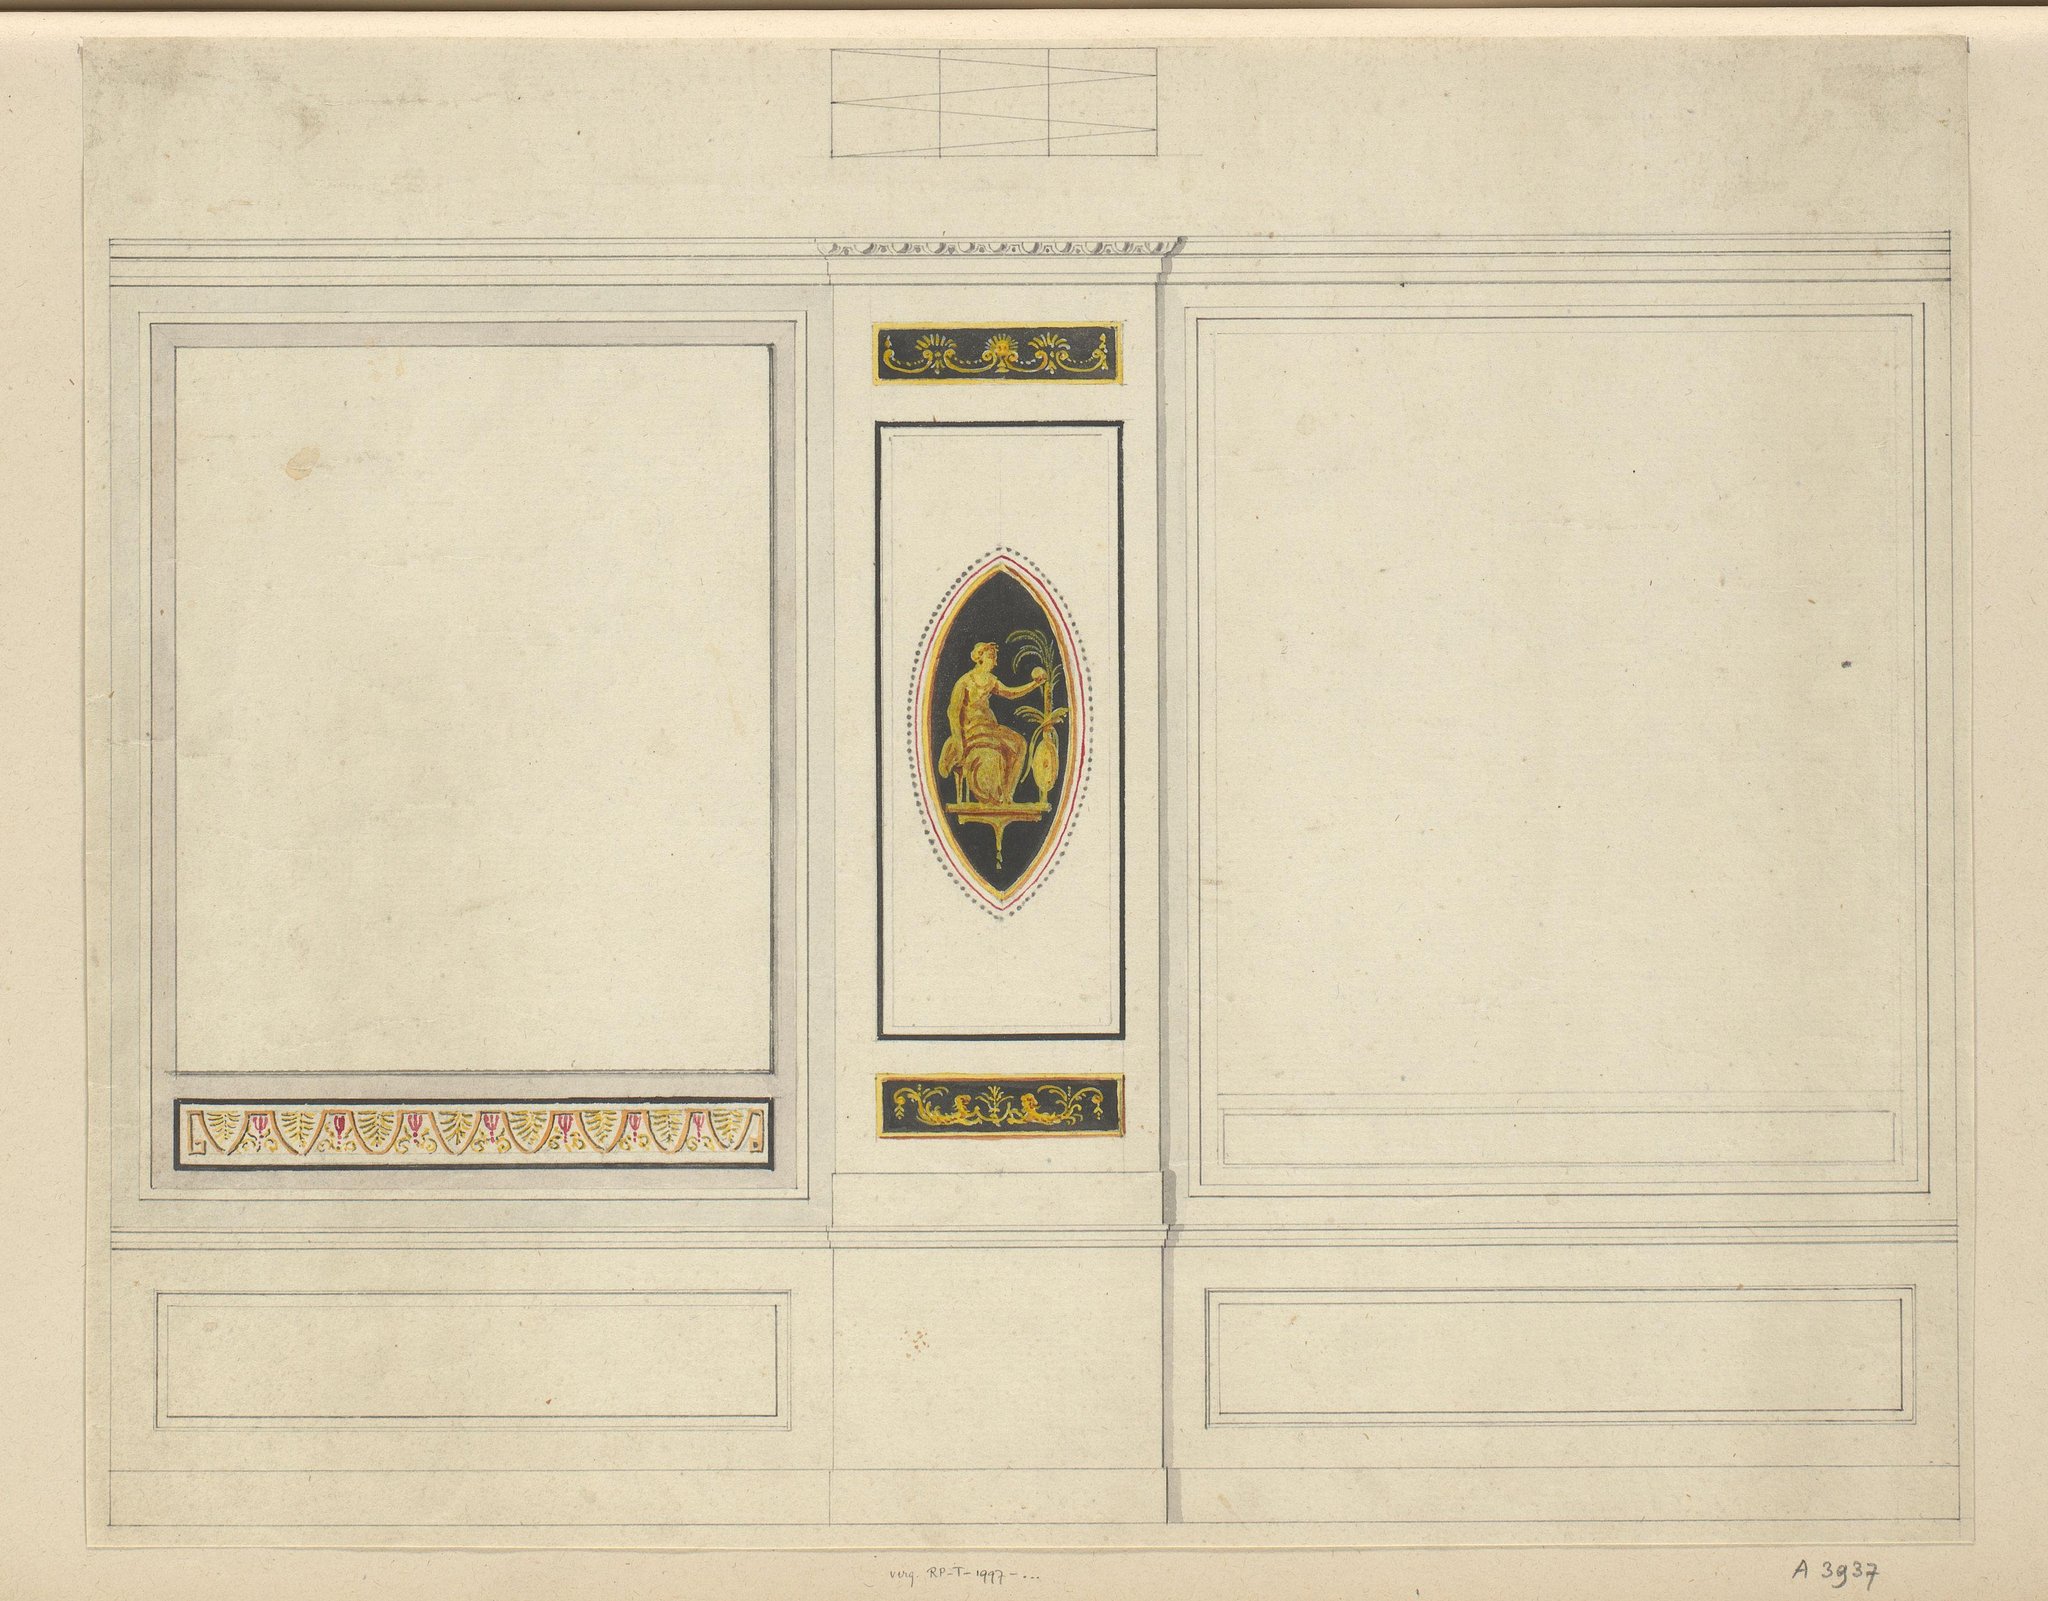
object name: album leaf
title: Ontwerptekening voor een kamerwand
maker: abraham van strij (i)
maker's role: draughtsman, painter, print maker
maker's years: 1753-1826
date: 1763-1826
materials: paint, paper, pencil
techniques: brush, pen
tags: wall-covering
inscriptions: inscription: Lugt 2228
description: De tekeningen van Abraham van Strij zijn op een later moment ingevoegd in het album met tekeningen van Jurriaan Andriessen.